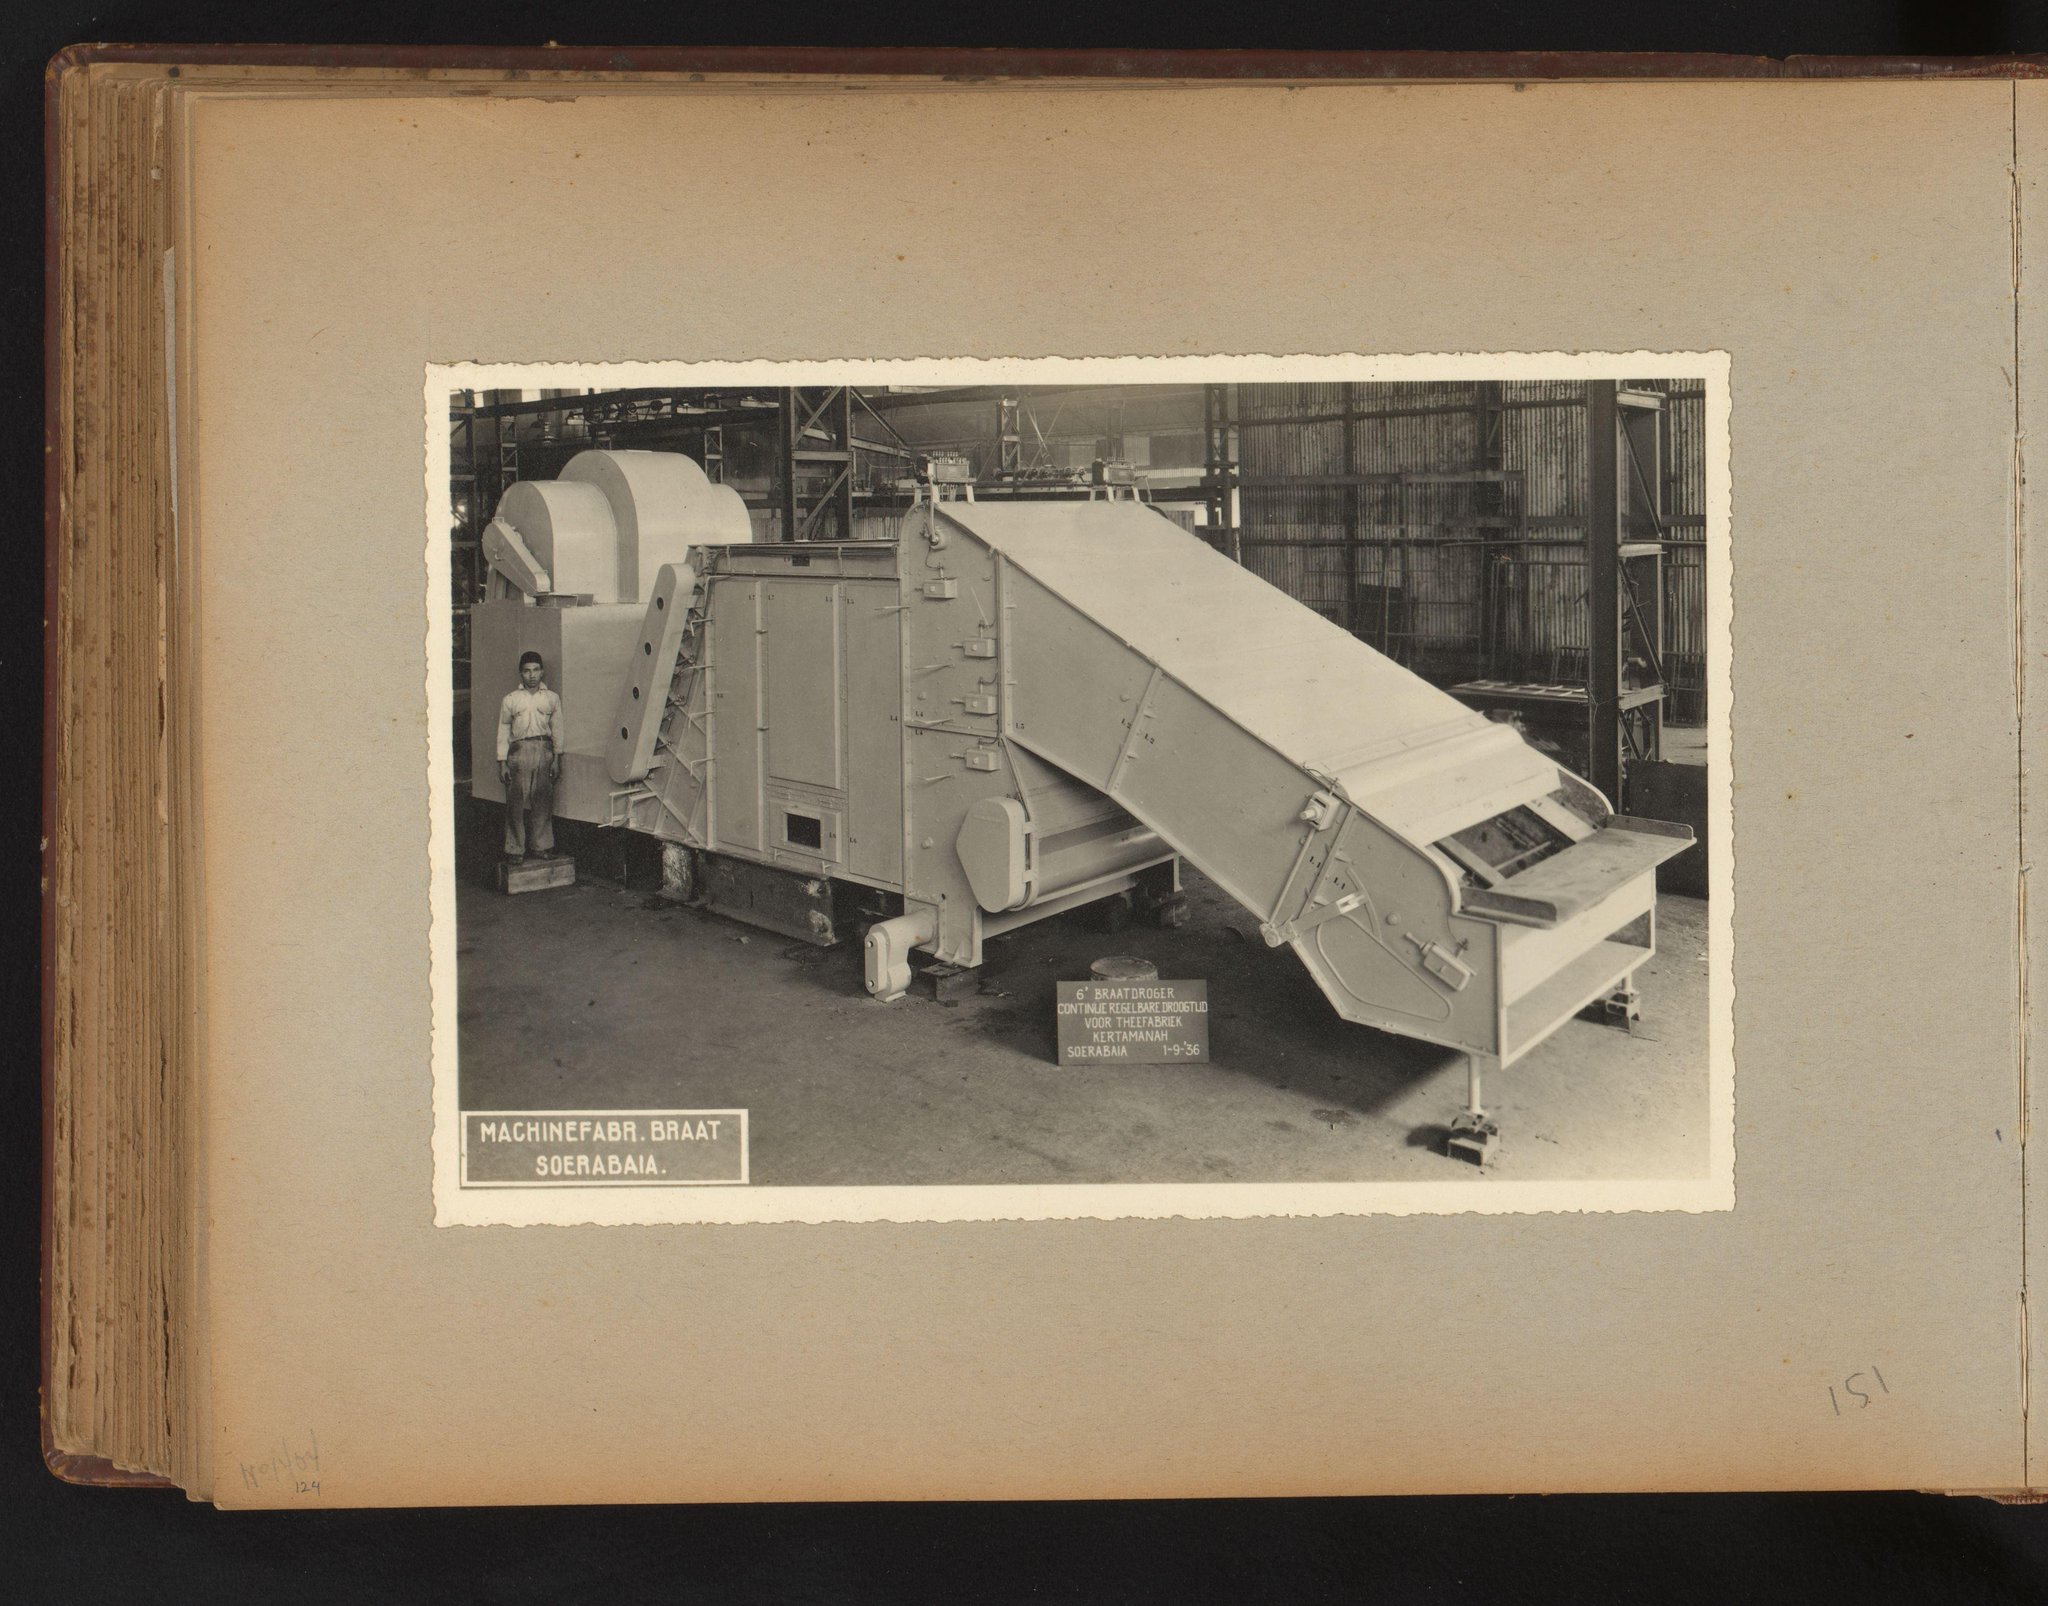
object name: photograph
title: Braatdroger voor de theefabriek Kertamanah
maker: Anonymous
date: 1936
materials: cardboard, photographic support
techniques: gelatin silver print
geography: surabaya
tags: machines; parts of machines; tools and appliances, java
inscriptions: date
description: Albumblad met een foto van een droogmachine, vervaardigd in 1936 en bestemd voor de theefabriek Kertamanah. Onderdeel van een fotoalbum met foto's van machines en constructies van de N.V. Machinefabriek Braat te Soerabaja, Soekaboemi en Tegal uit de periode 1931-1937.